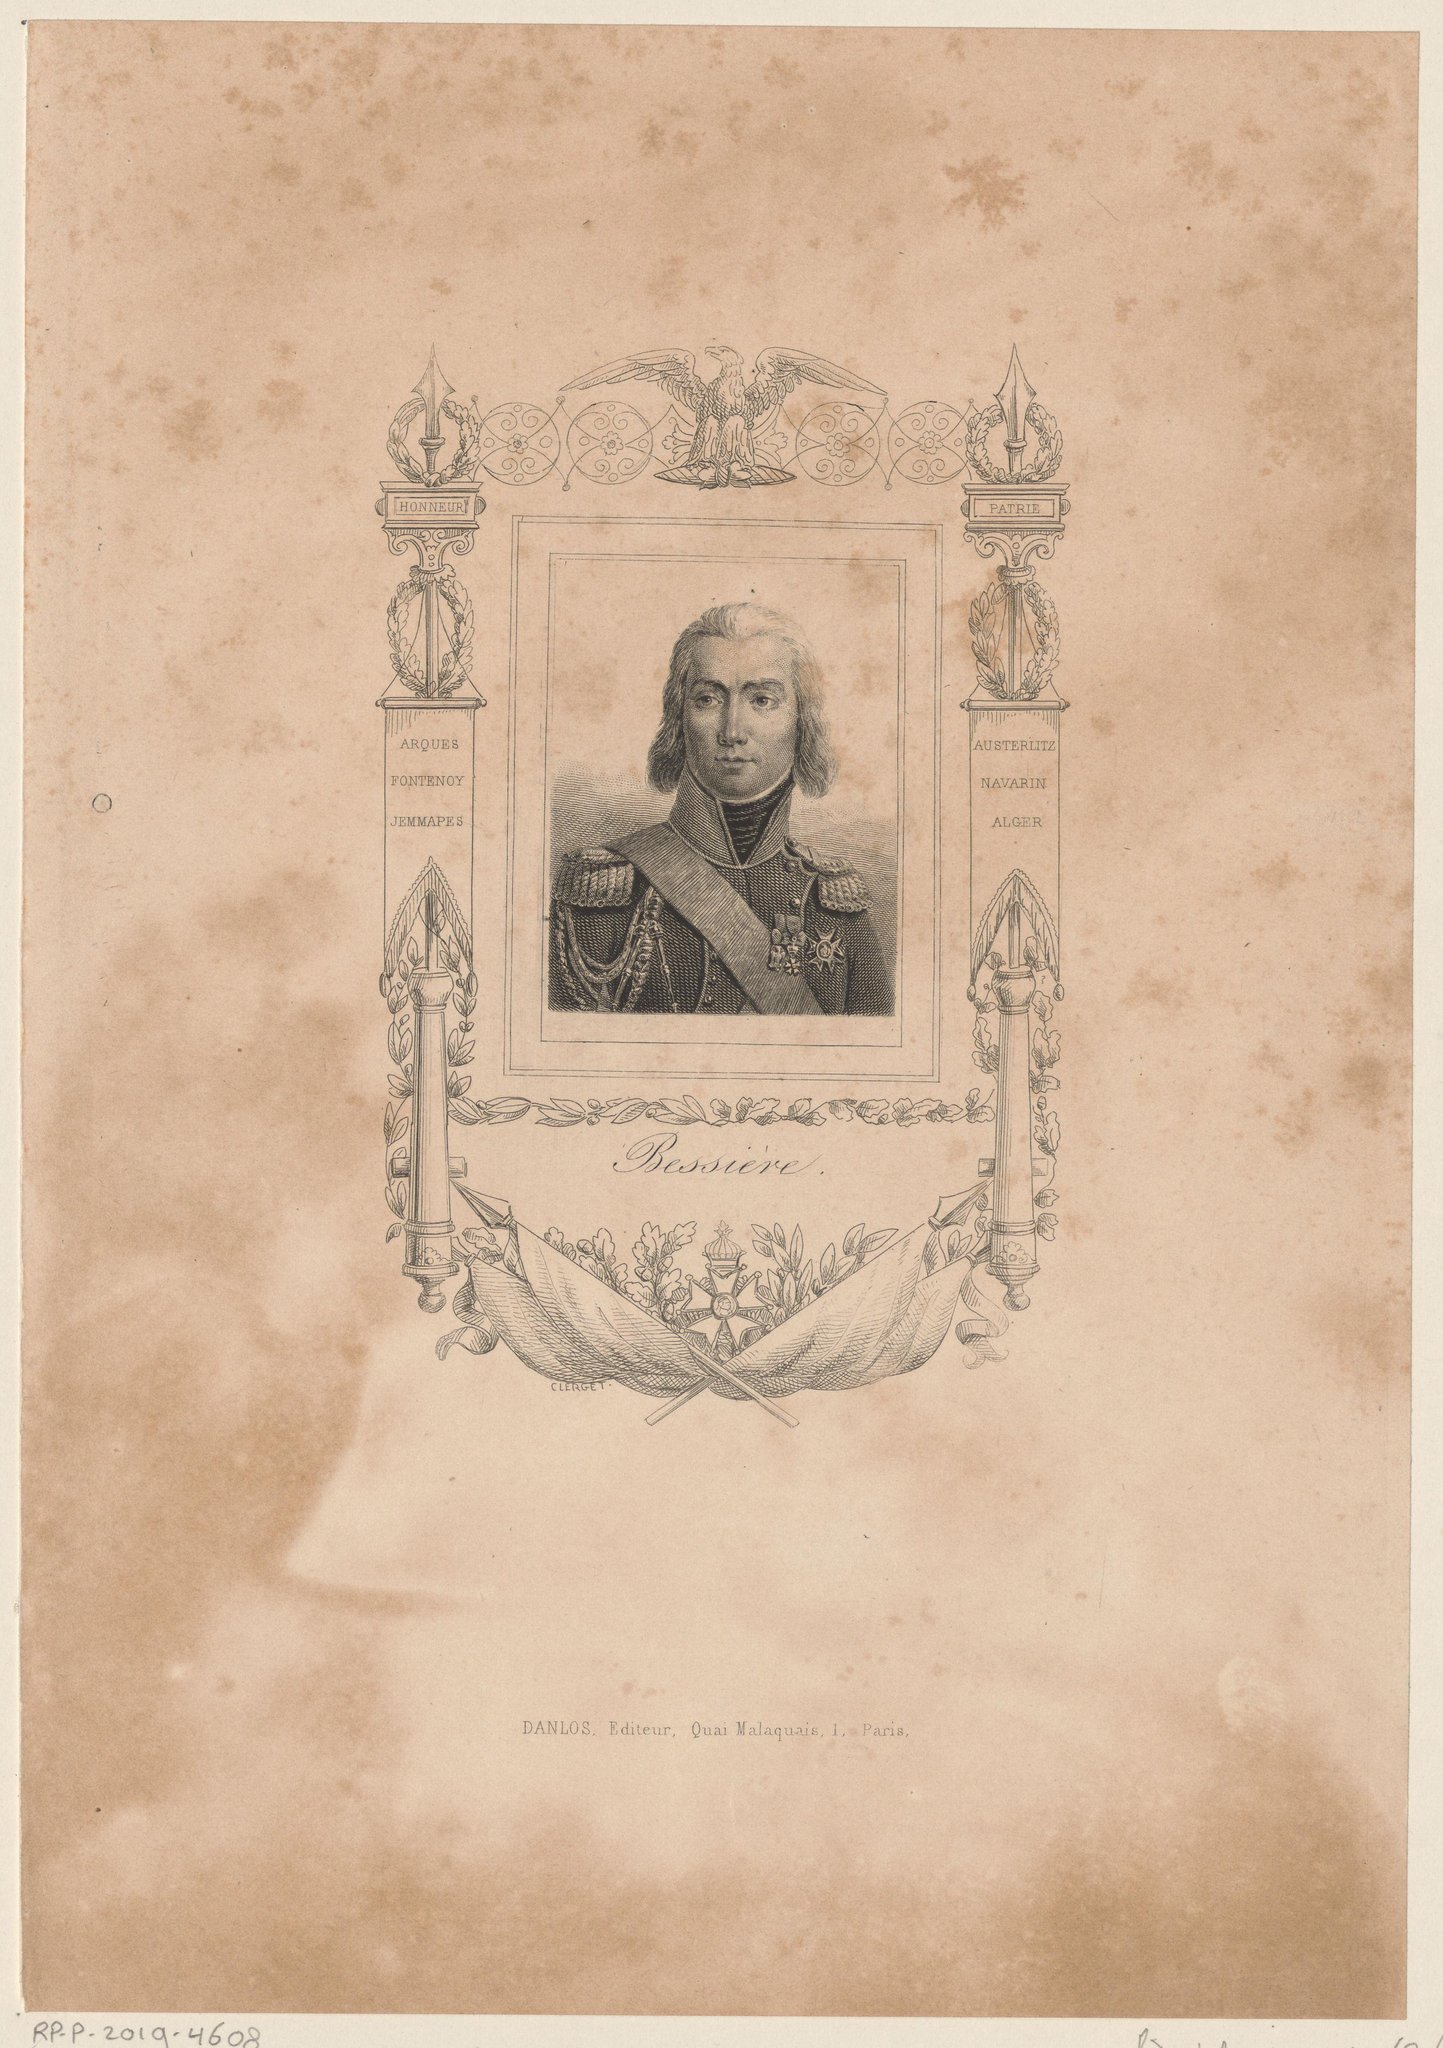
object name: print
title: Portret van Jean-Baptiste Bessières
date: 1830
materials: paper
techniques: etching, engraving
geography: paris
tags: historical persons